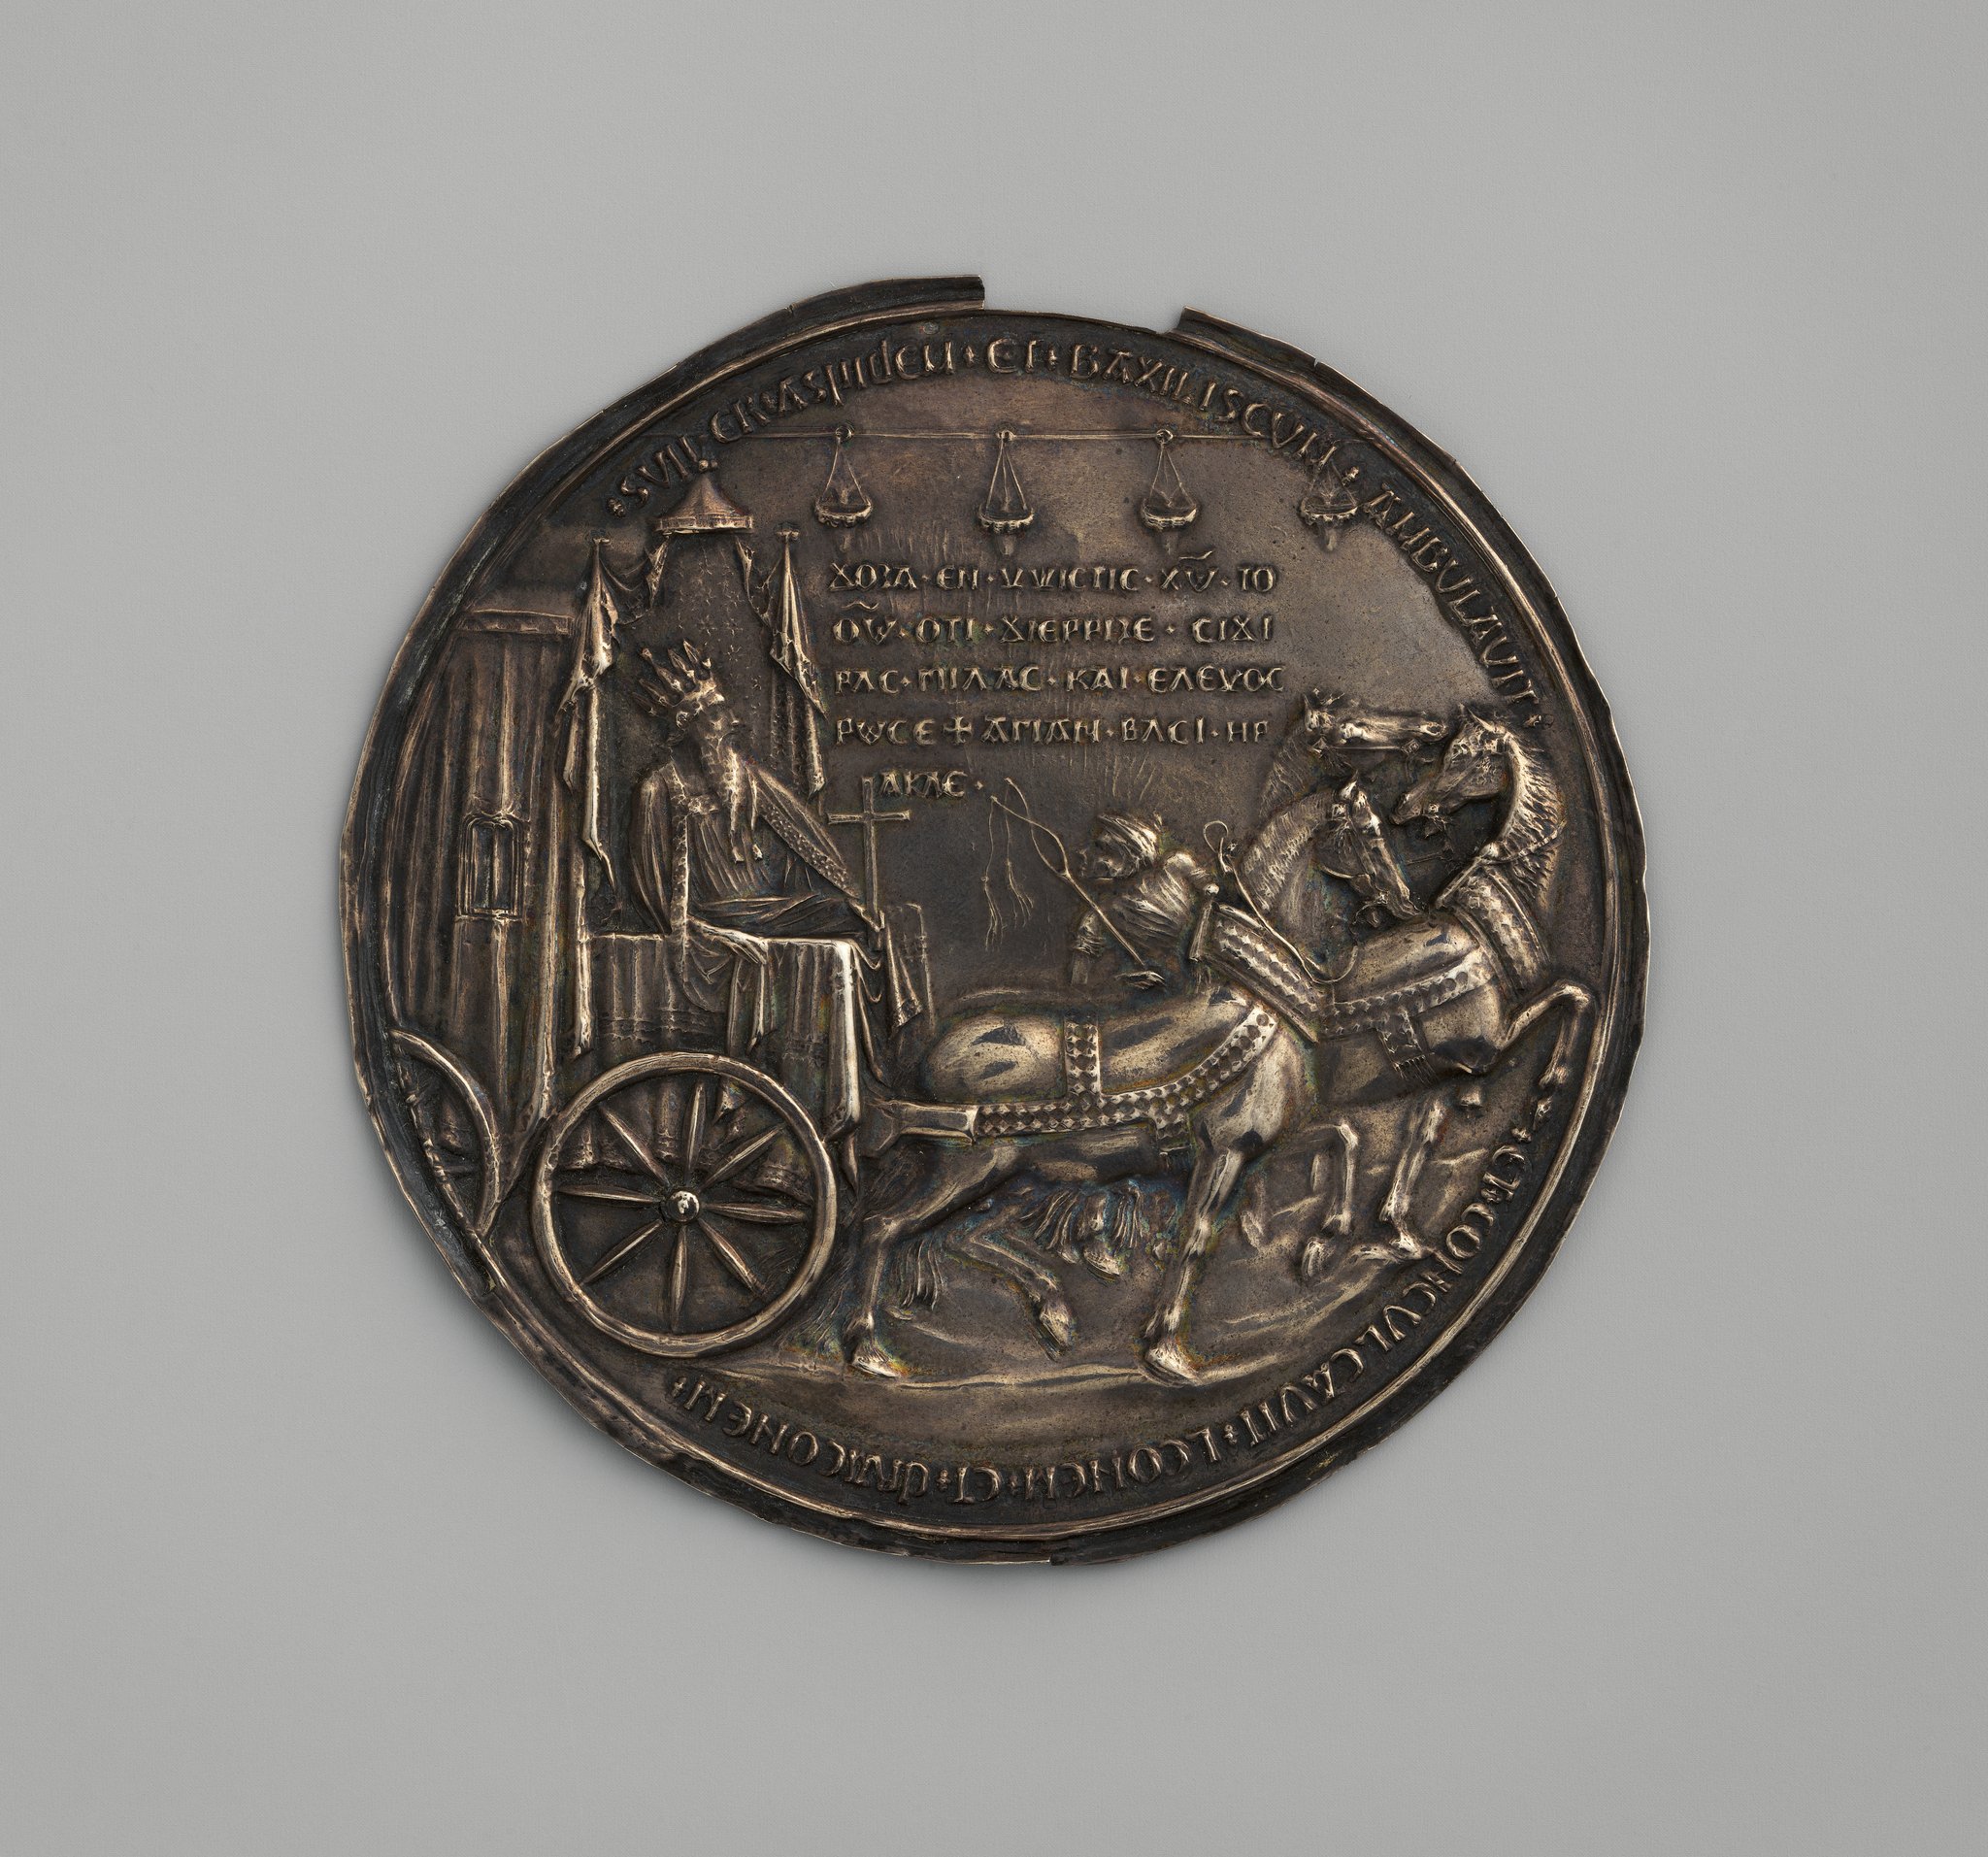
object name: medal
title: Heraklios Approaching the Gates of Jerusalem with the True Cross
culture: french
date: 1402-1413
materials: silver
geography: france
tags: men,horses,chariots